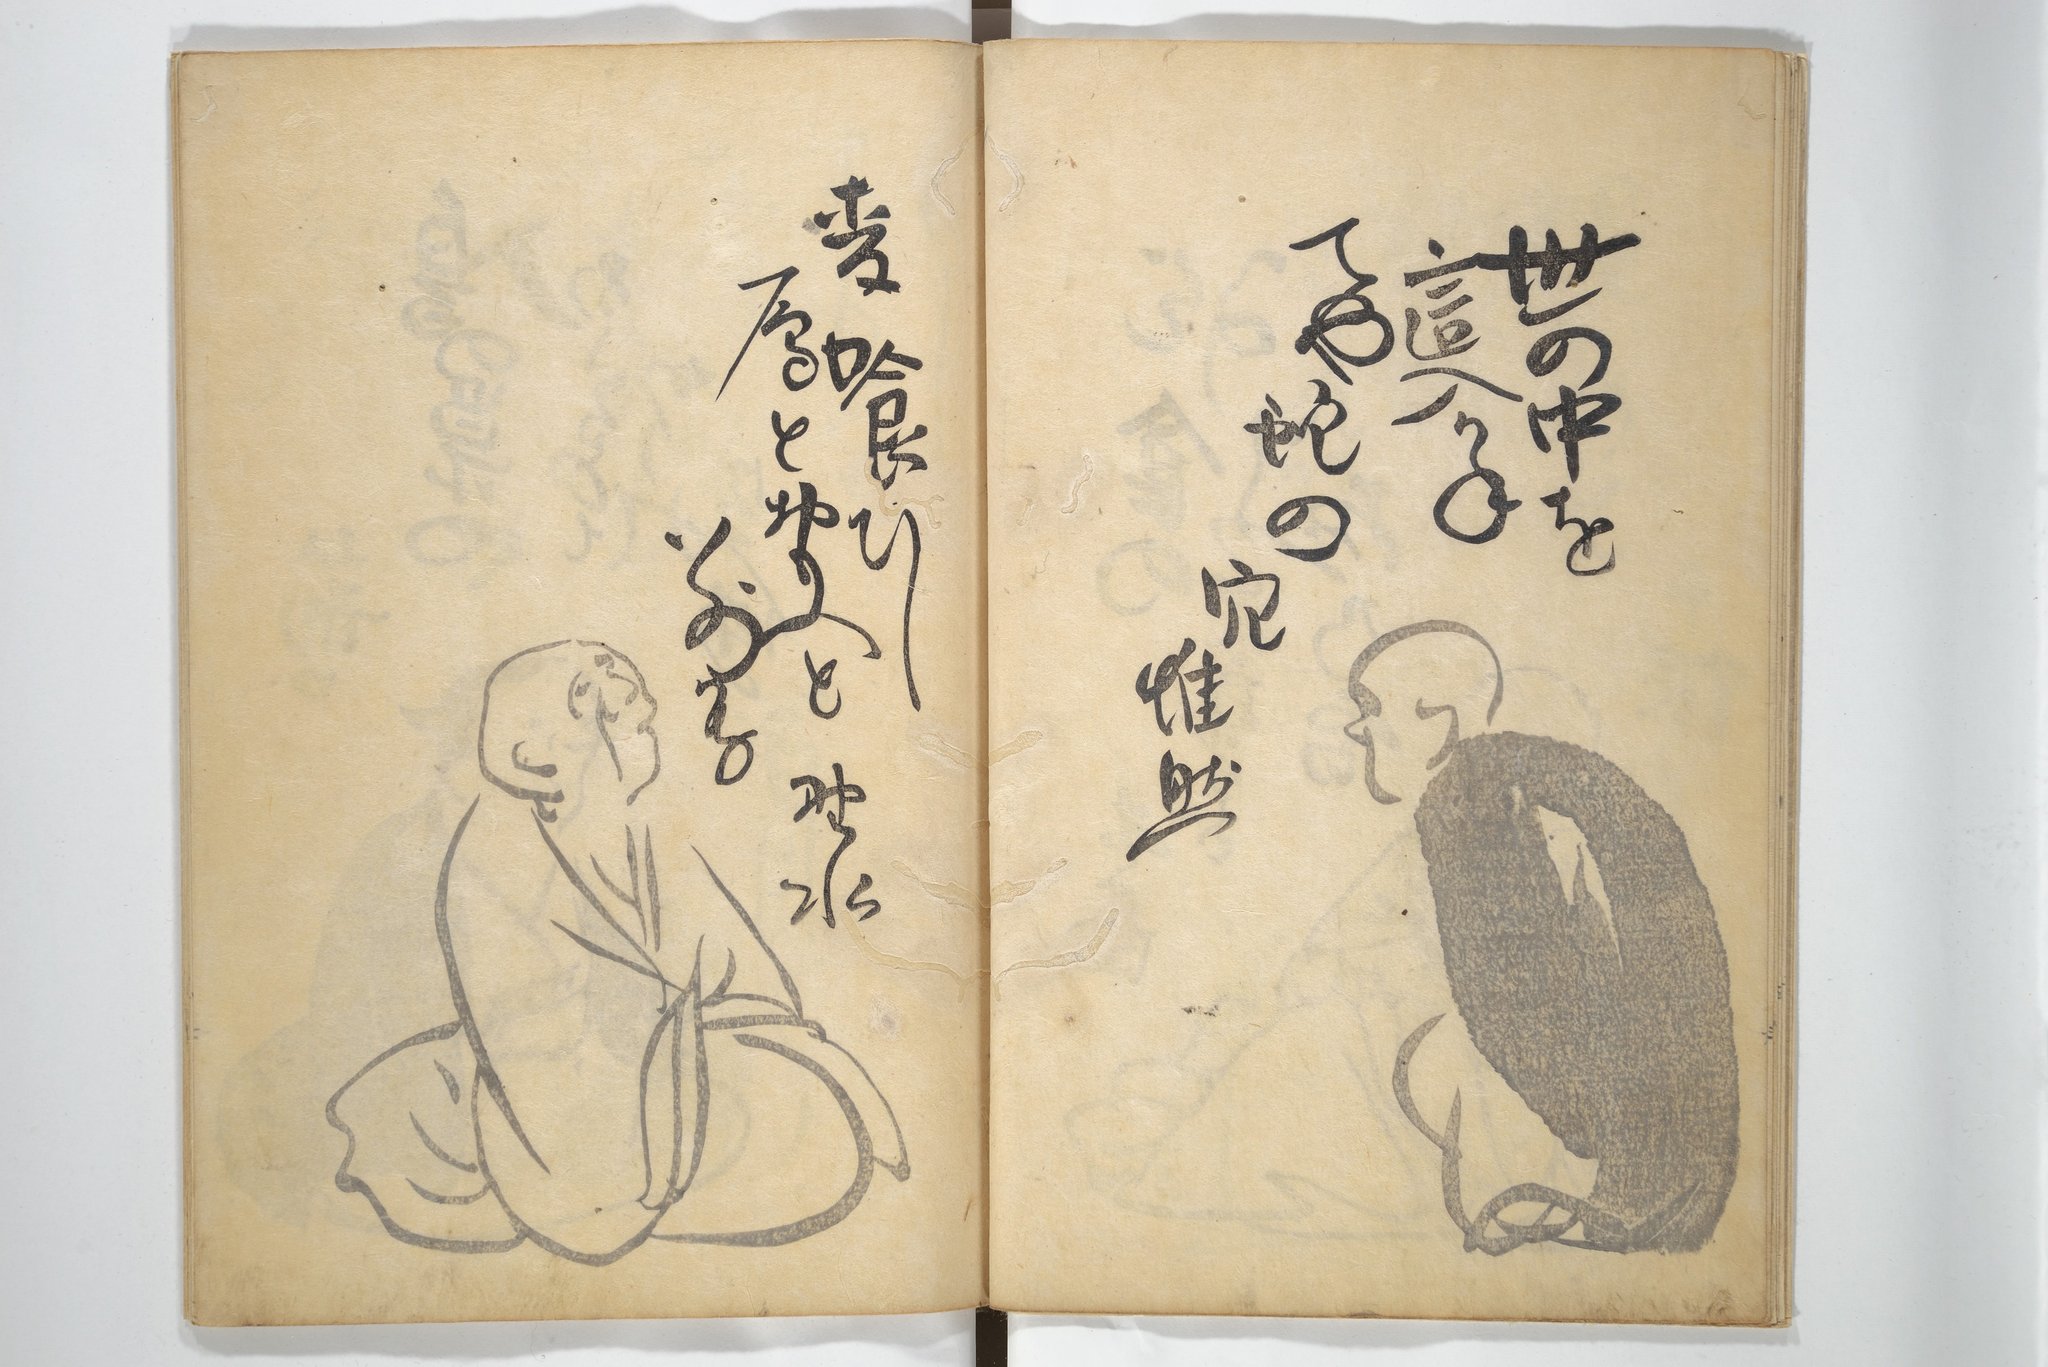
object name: illustrated book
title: The Thirty-six Immortals of Poetry (Sanjūrokkasen) 三十六歌仙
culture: japanese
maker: yosa buson 与謝蕪村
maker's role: artist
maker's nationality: japanese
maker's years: 1716-1783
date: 1799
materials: ink, paper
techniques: woodblock print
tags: men